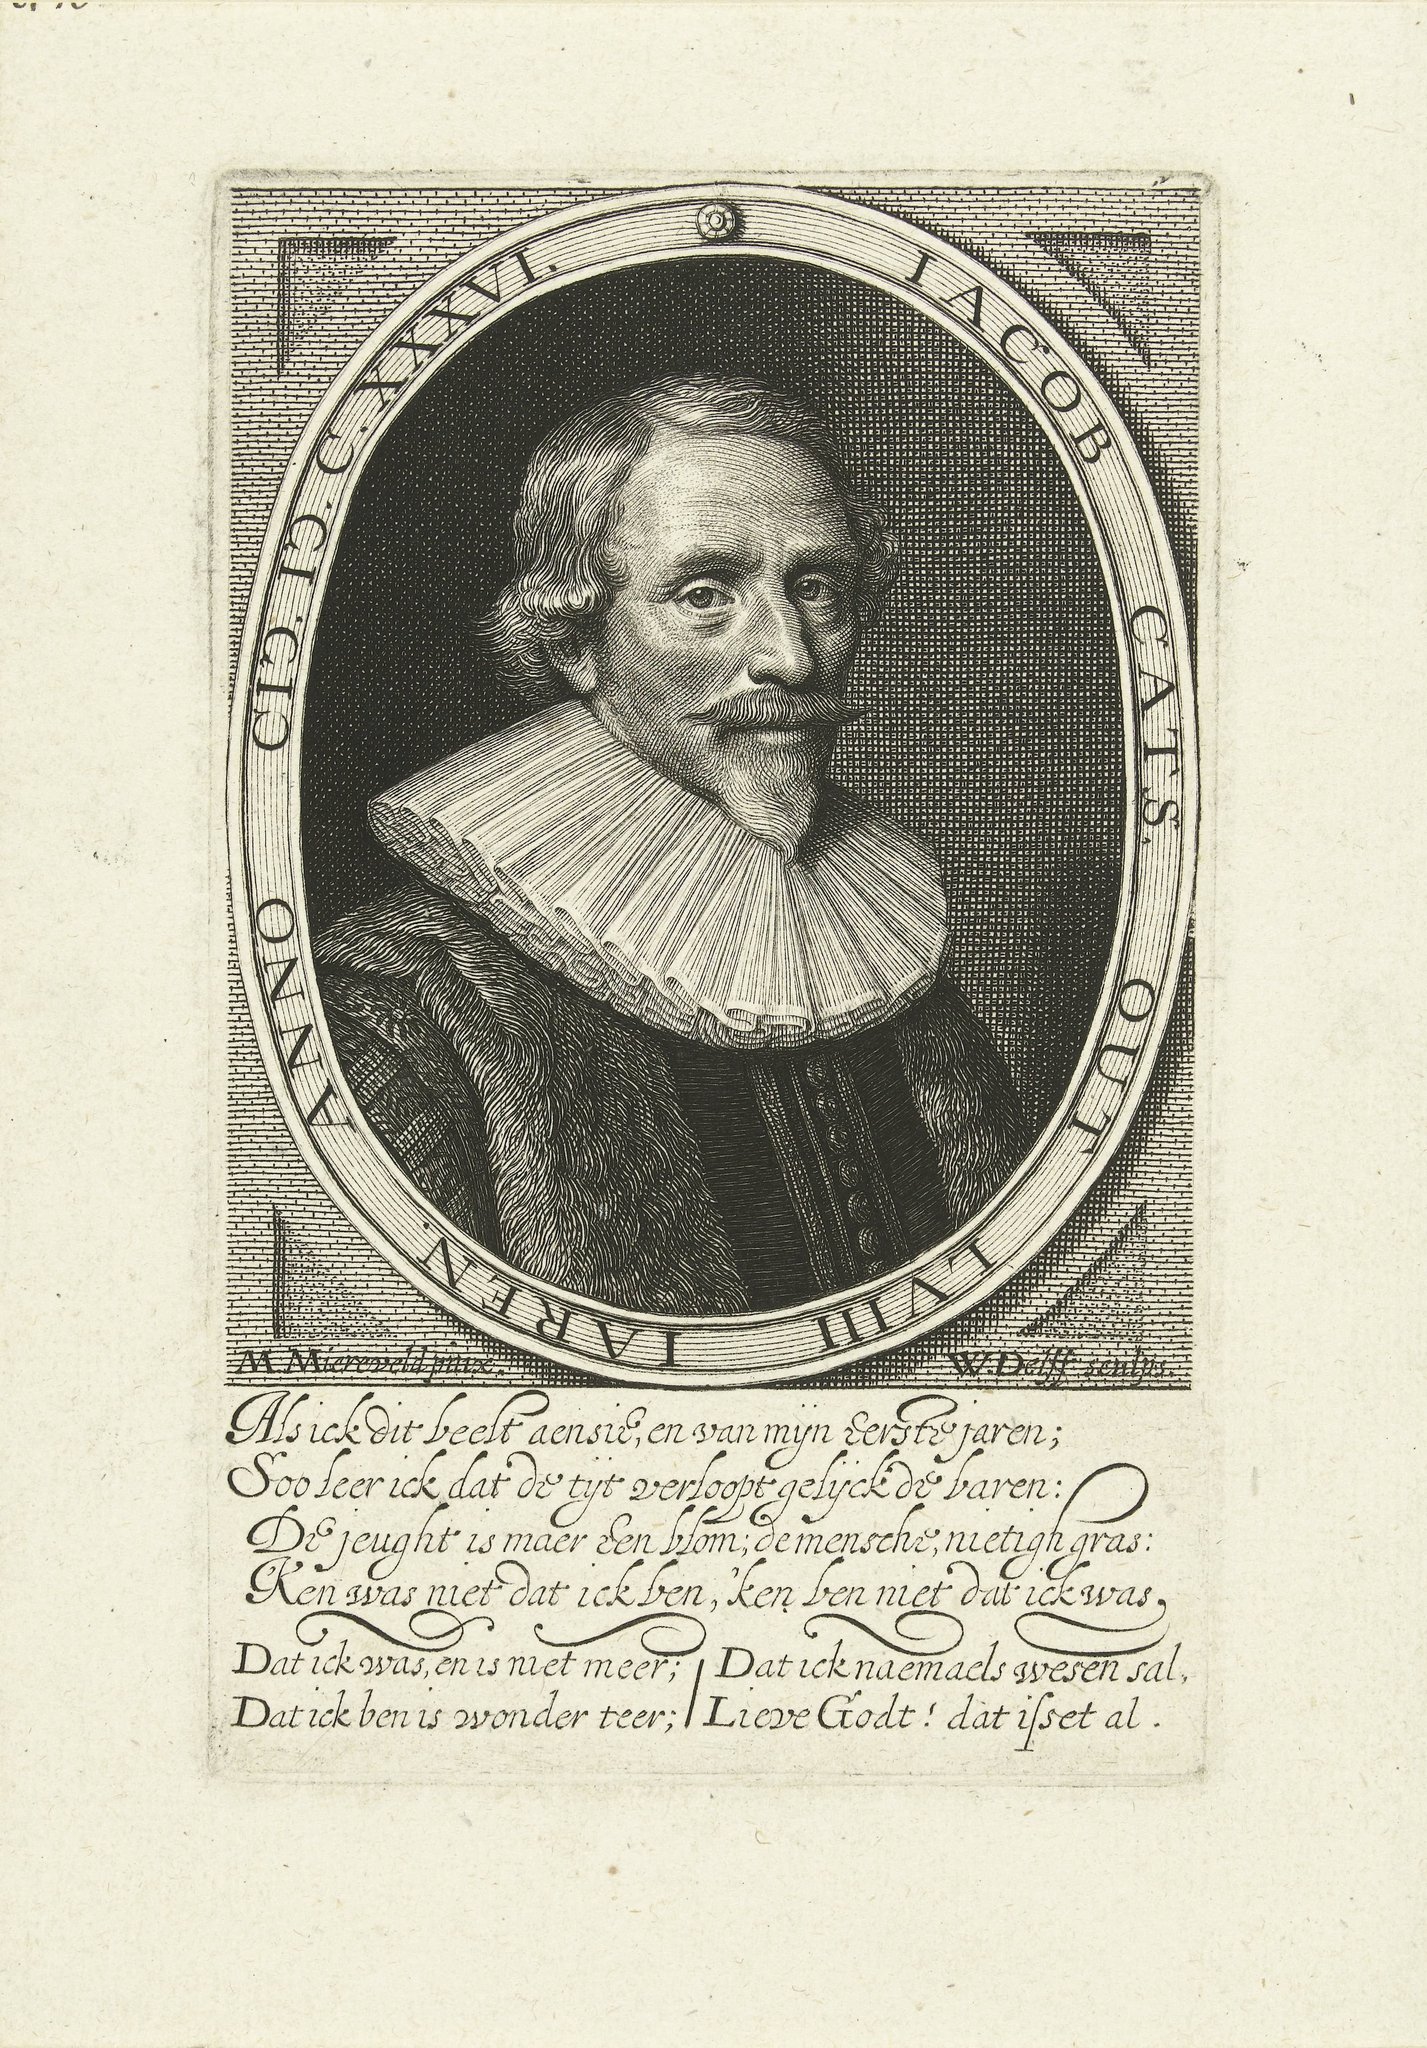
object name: print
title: Portret van Jacob Cats op 58-jarige leeftijd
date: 1636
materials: paper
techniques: engraving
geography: delft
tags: the hague, jacob cats (1577-1660), portrait of a writer, neck-gear: collar (+ men's clothes)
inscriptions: collector's mark: Lugt 240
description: Portret van Jacob Cats op 58-jarige leeftijd, borststuk met plooikraag en toga. Ovale omlijsting met opschrift, twee Nederlandse verzen, mogelijk van Jacob Cats.